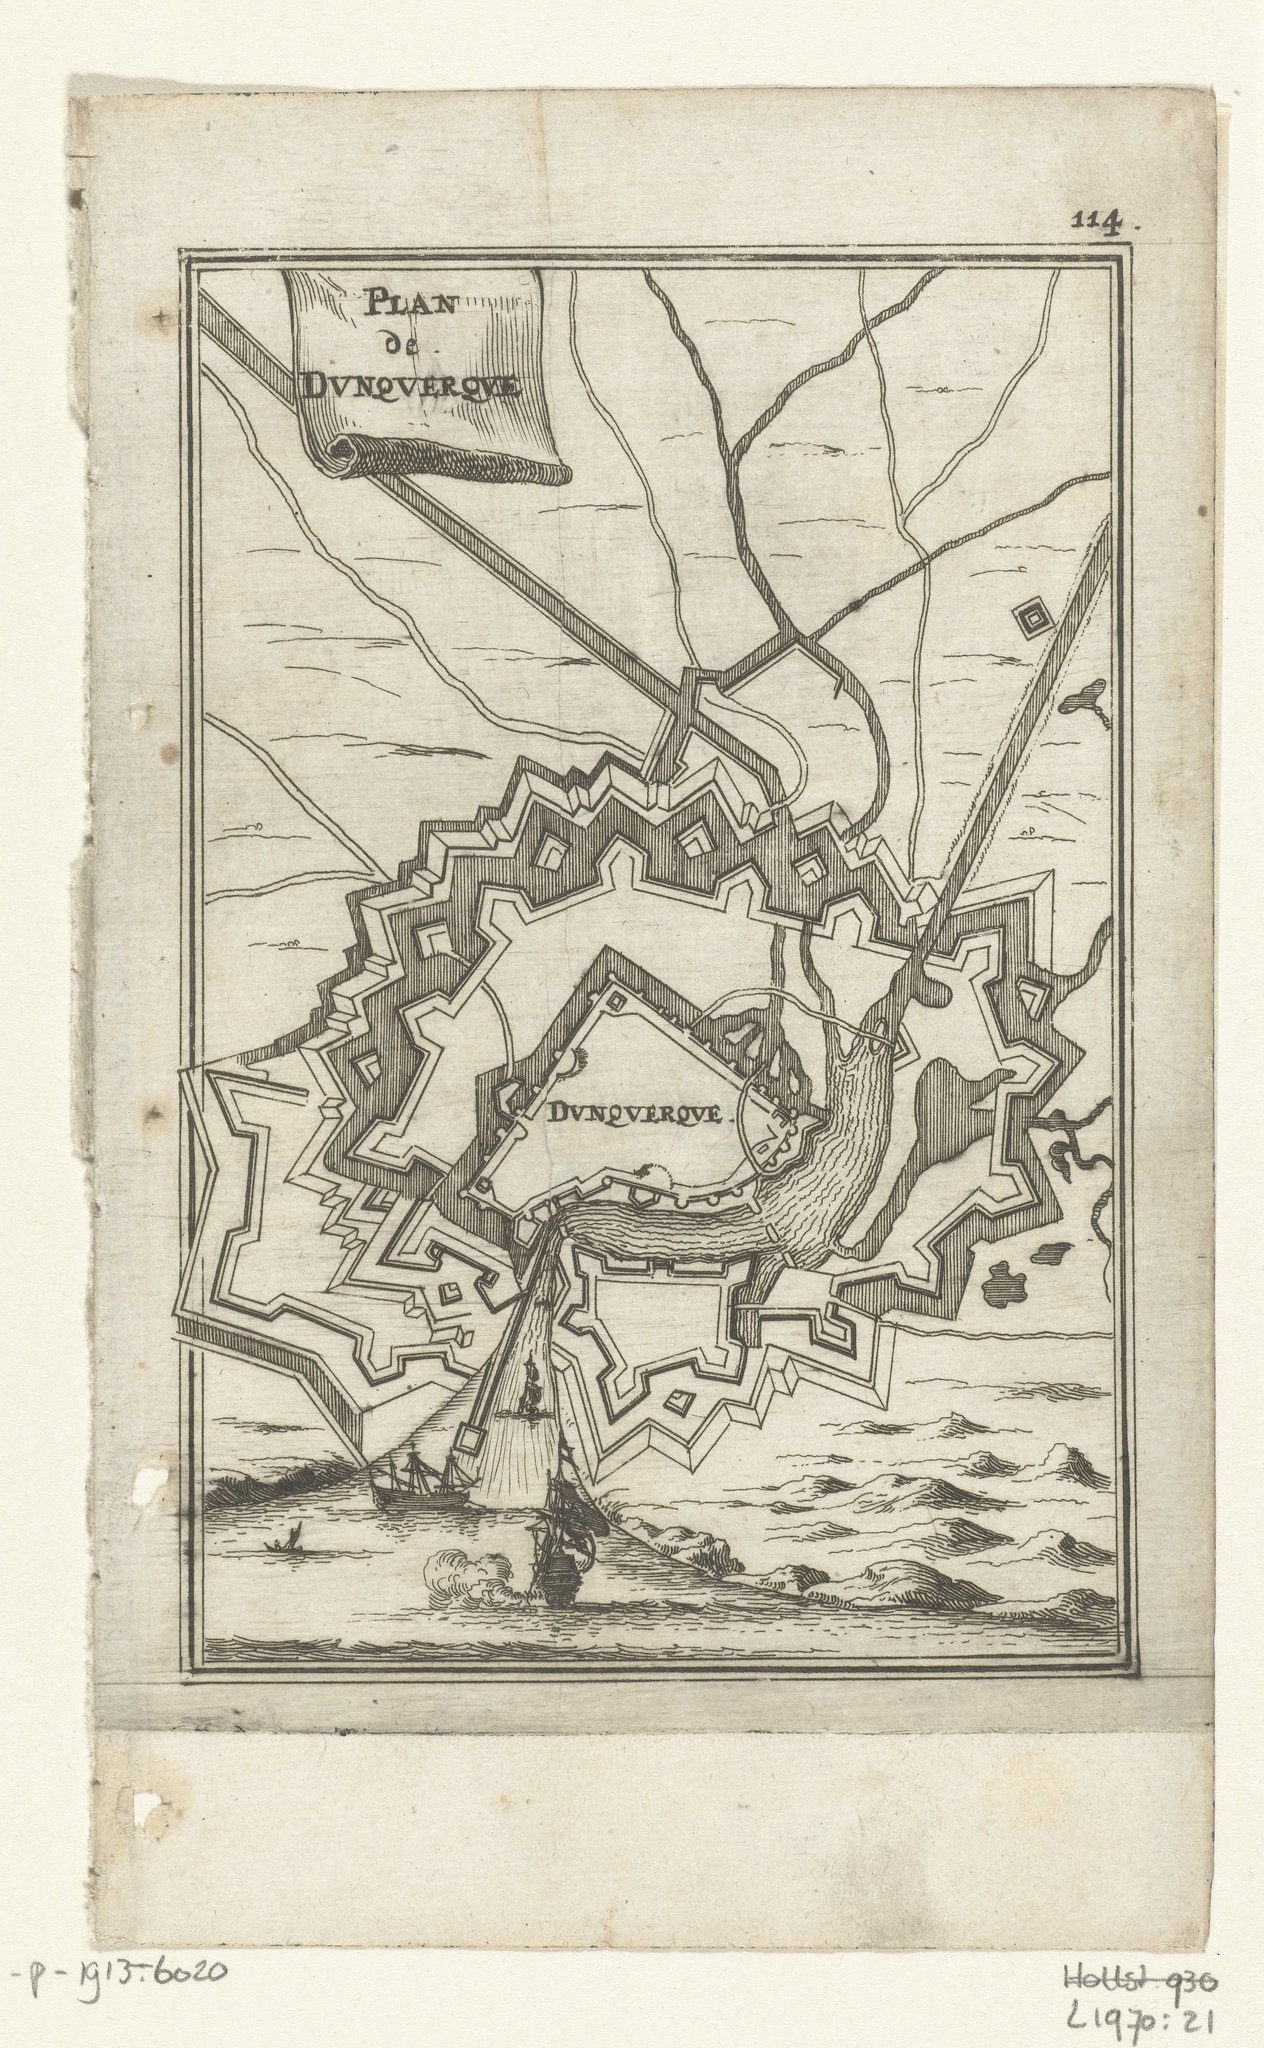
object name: book illustration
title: Illustratie voor 'Den Arbeid van Mars' van Allain Manesson Mallet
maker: romeyn de hooghe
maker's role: draughtsman, goldsmith, painter, print maker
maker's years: 1645-1708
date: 1672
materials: paper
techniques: engraving, etching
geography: amsterdam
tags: city-view in general; 'veduta', ships (in general), sea (seascape), fortifications, military engineering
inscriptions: collector's mark: Lugt 2228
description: Illustratie voor: Allain Manesson Mallet, 'Den Arbeid van Mars' (3 delen, Amsterdam: Jacob van Meurs of Amsterdam: Jacob van Meurs en Johannes (I) Janssonius van Waesberge, 1672). Klinkert, C.